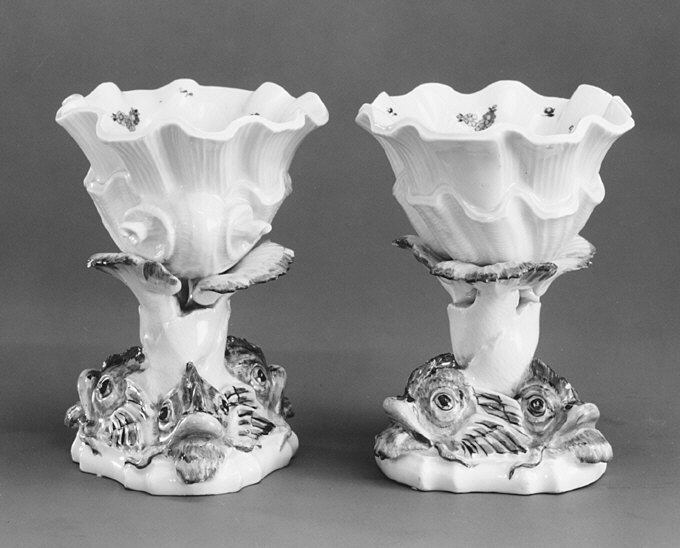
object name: orange stand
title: Pair of orange stands (part of a service)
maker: meissen manufactory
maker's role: manufactory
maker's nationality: german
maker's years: 1710-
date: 1738-1741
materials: hard paste porcelain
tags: flowers